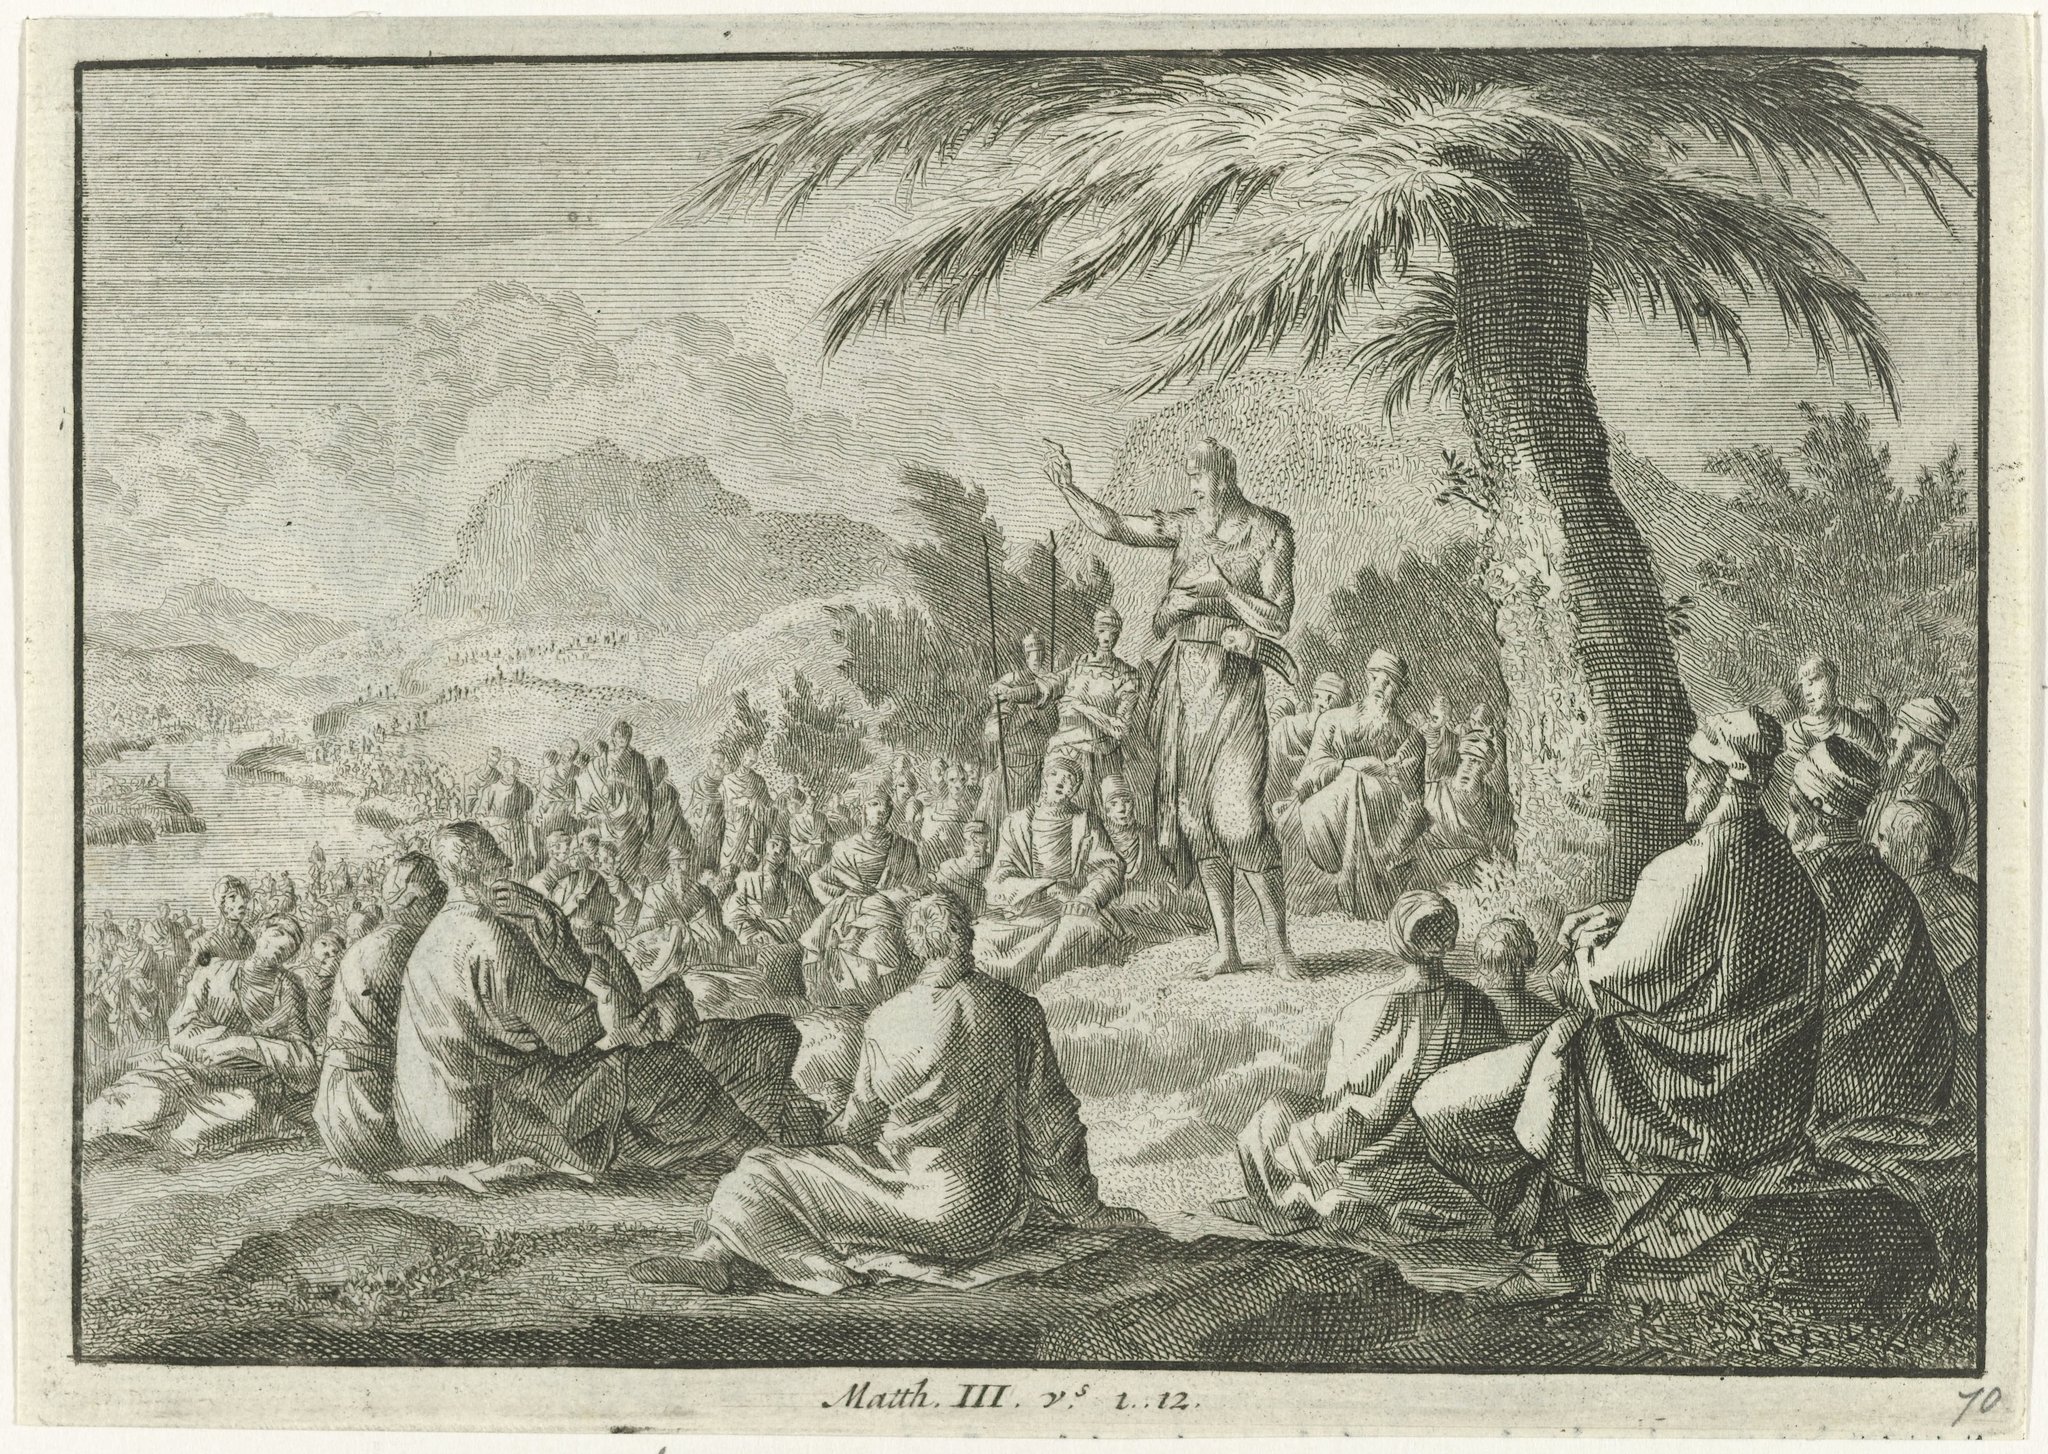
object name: print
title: Prediking van Johannes de Doper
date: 1703-1762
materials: paper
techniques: etching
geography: amsterdam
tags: john the baptist preaching (perhaps christ among the bystanders)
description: De prent komt een eerste keer voor als boekillustratie voor David Martin. Historie des Ouden en Nieuwen Testaments. Amsterdam, Pieter Mortier, 1703. Deel II. De boekillustraties voor de Mortierbijbel hebben verschillende staten en kopieën, waarbij de chronologische volgorde moeilijk te achterhalen valt. Als boekillustraties werden ze bovendien herhaaldelijk opnieuw gebruikt voor andere boekwerken.